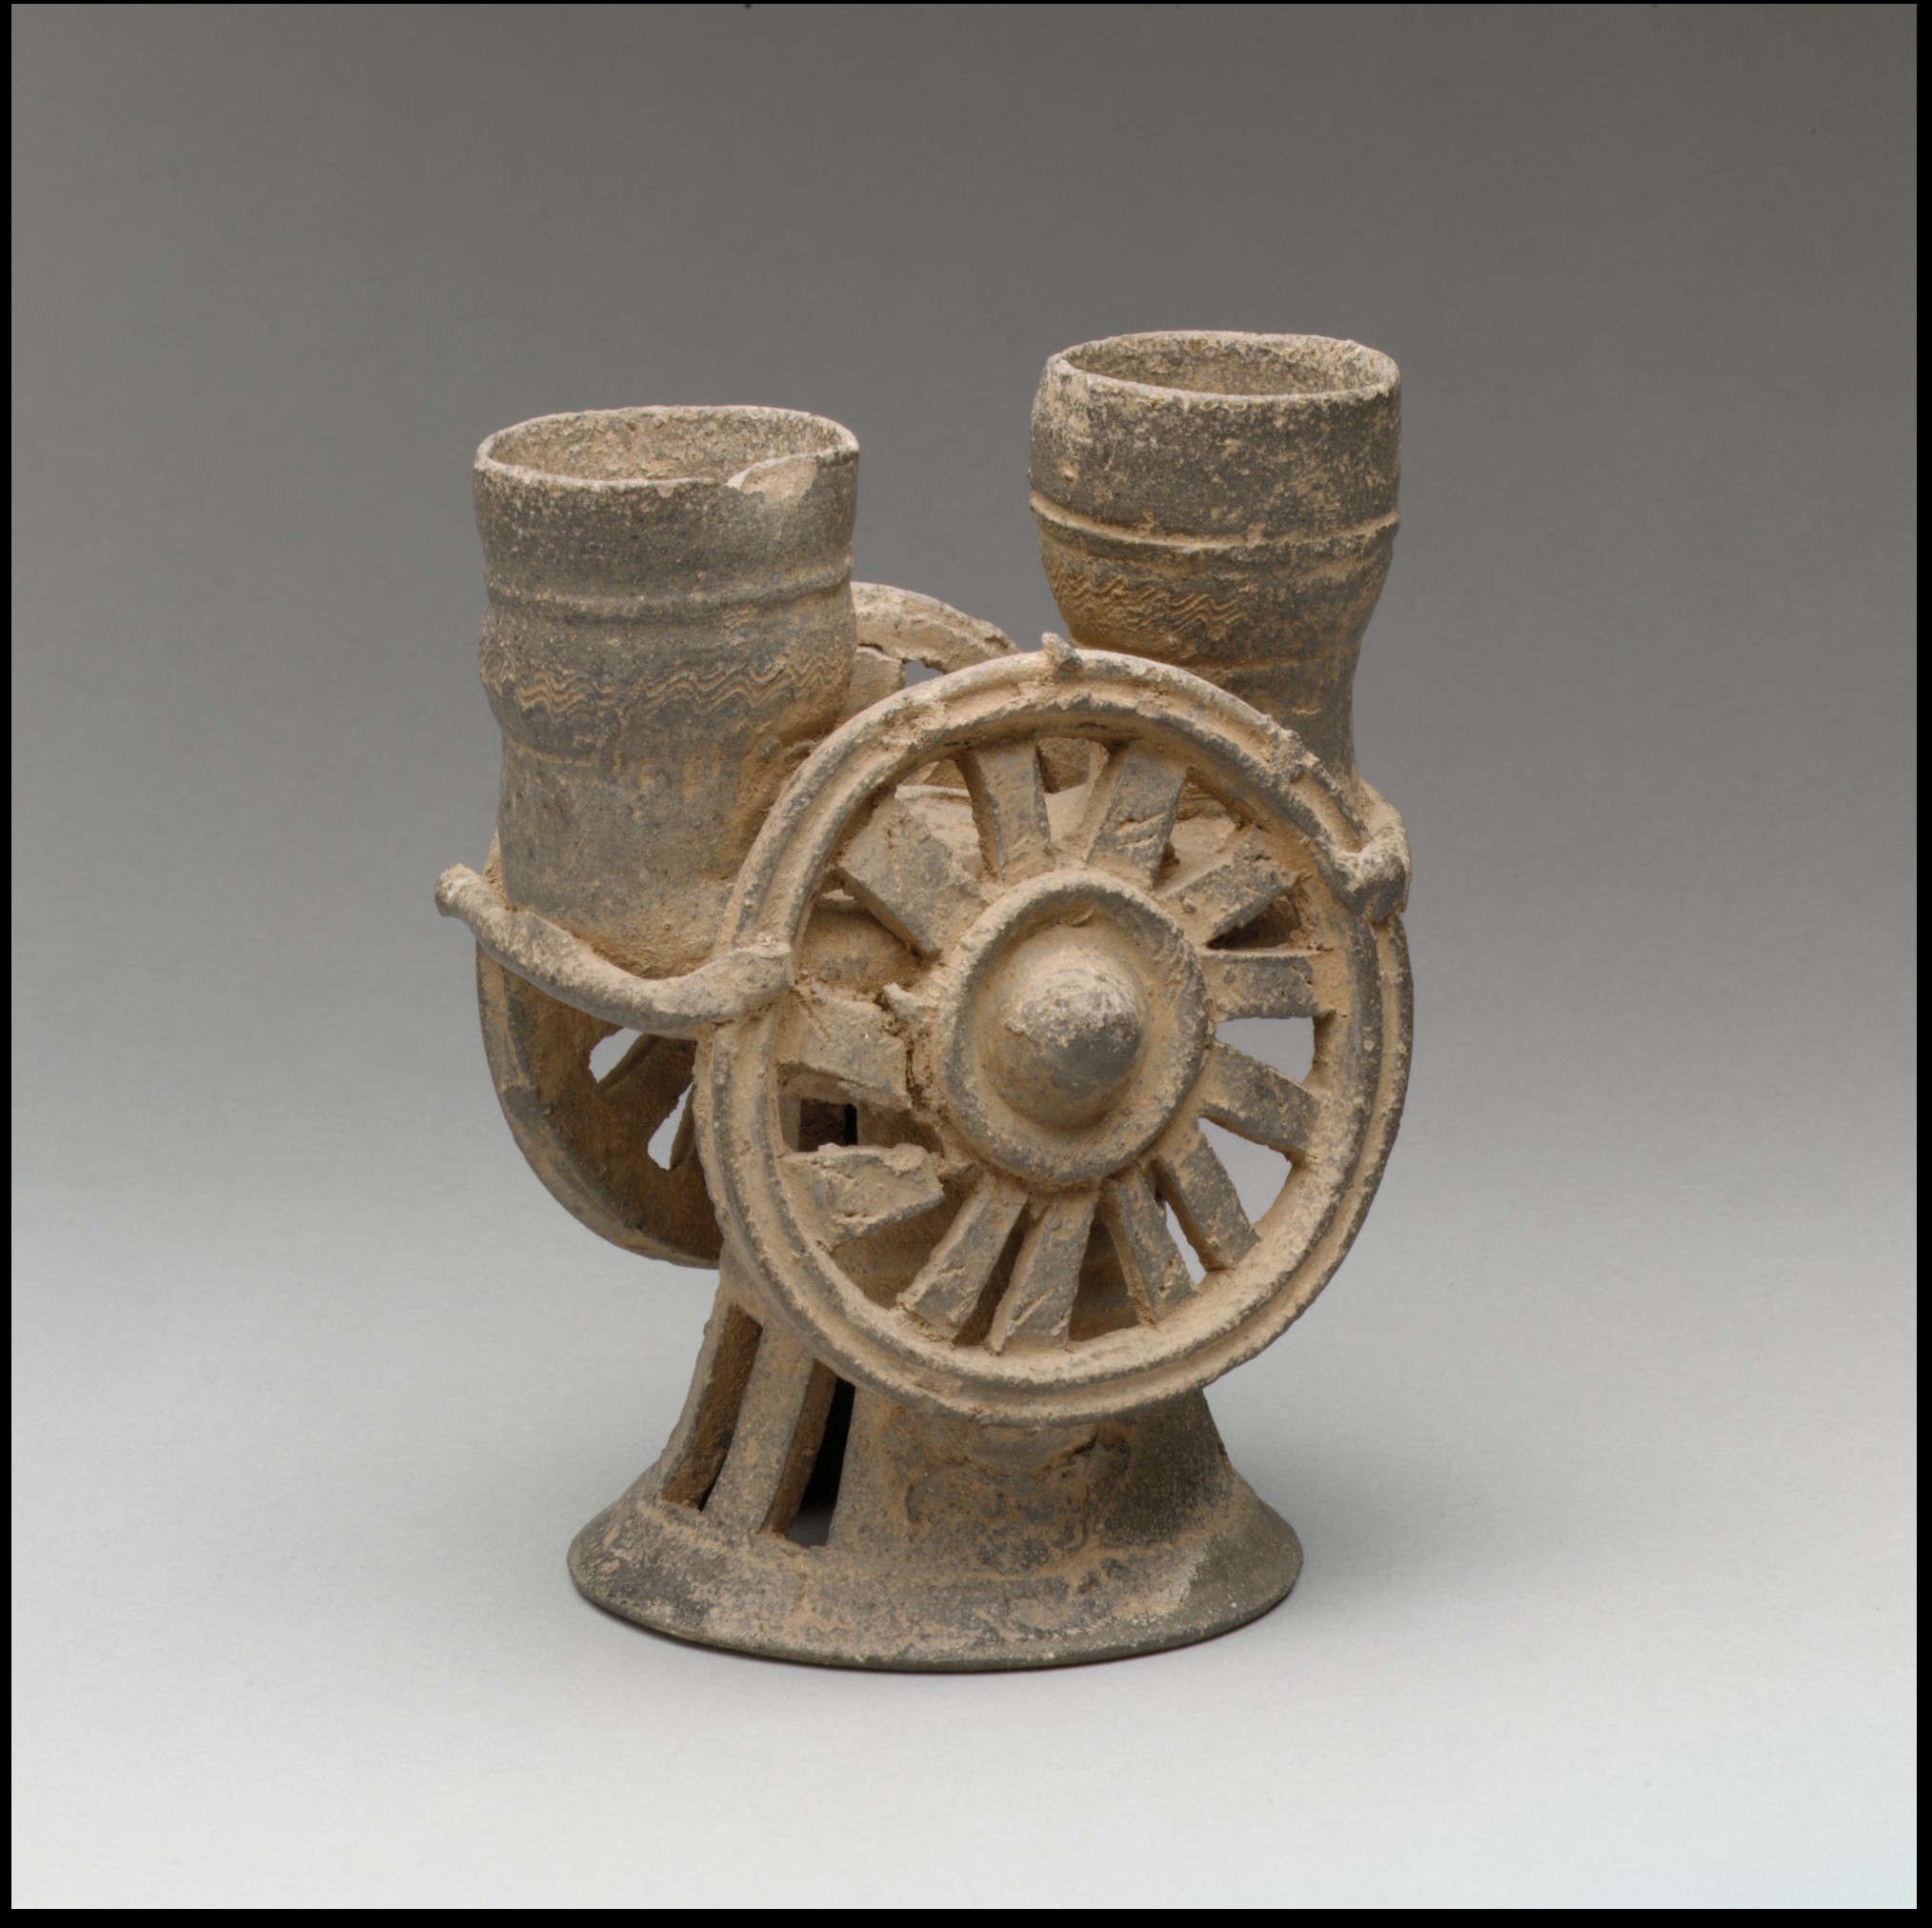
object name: cup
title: Chariot wheel-shaped cup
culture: korean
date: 401-500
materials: wood, glaze, stoneware